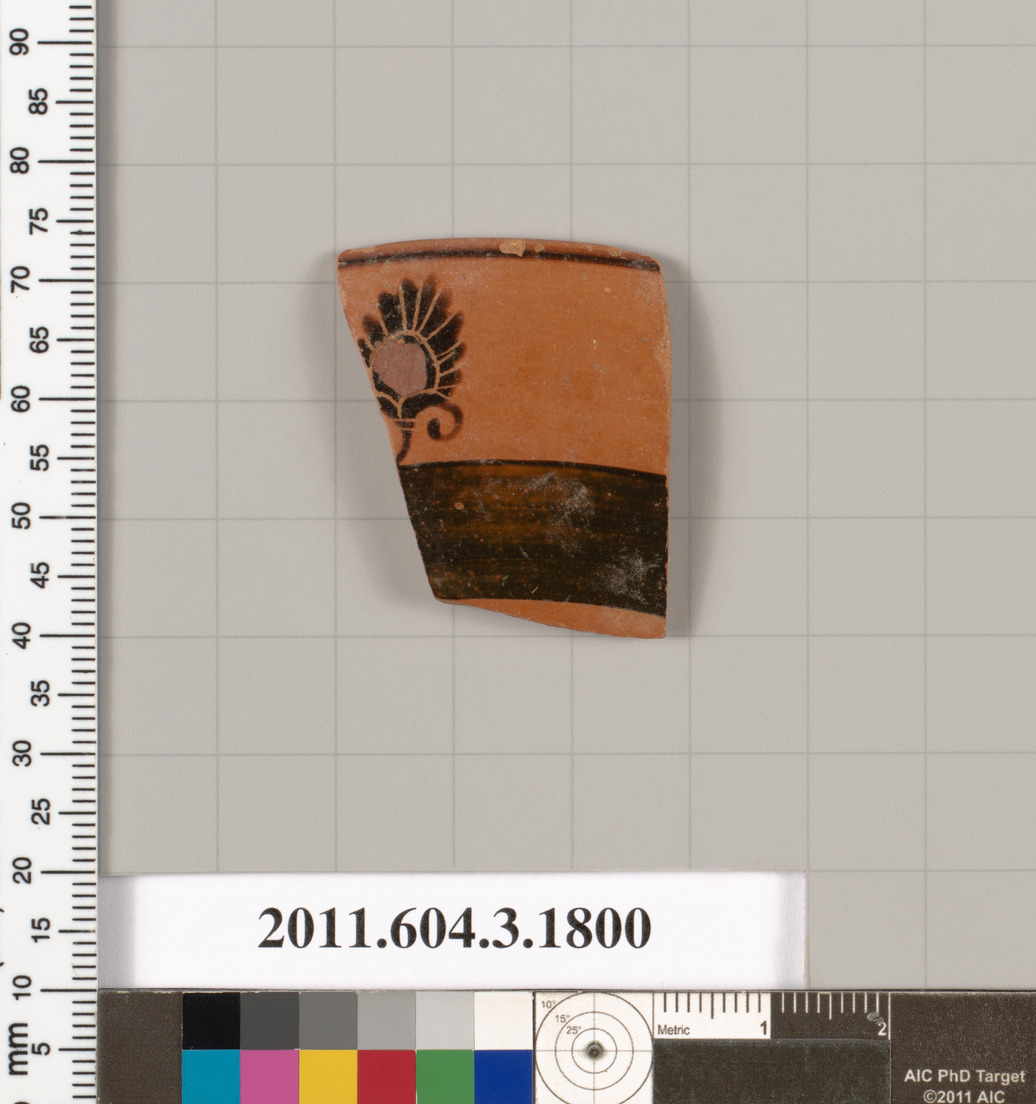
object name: kylix fragment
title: Terracotta fragment of a kylix: Lip cup (drinking cup)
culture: greek, attic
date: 550-526 BCE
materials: terracotta